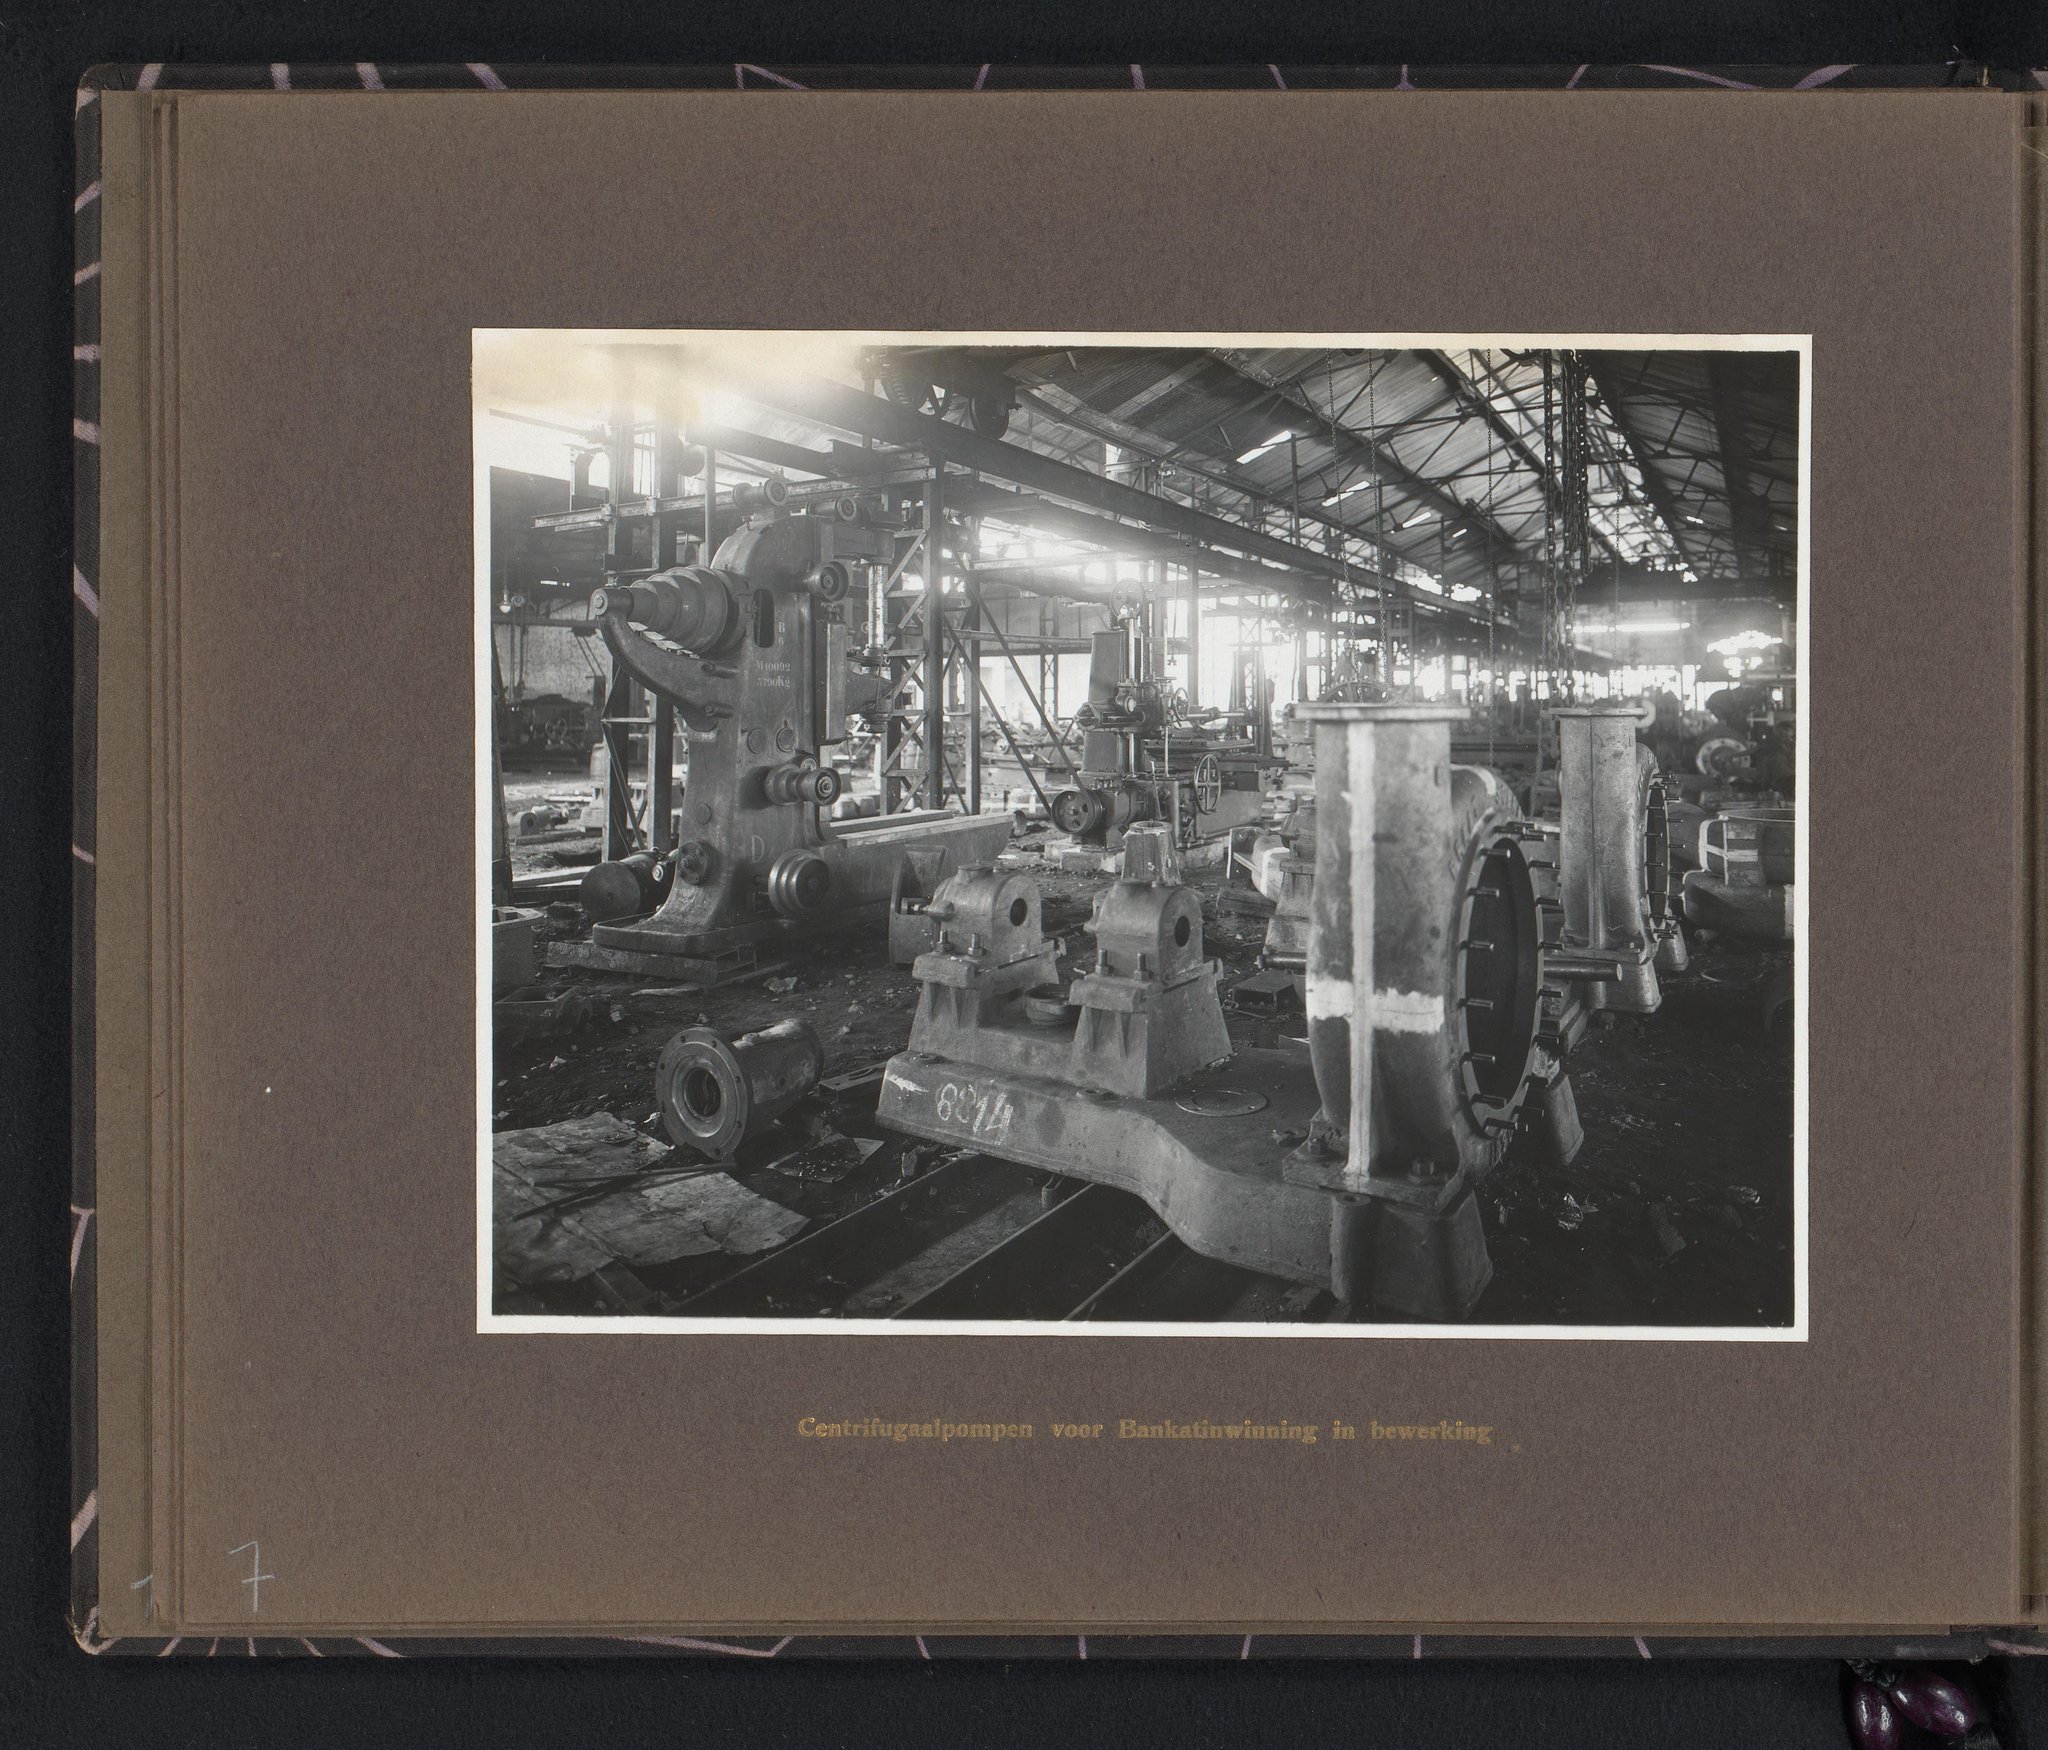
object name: album leaf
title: Centrifugaalpompen voor Bankatinwinning in bewerking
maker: Anonymous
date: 1916-1924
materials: cardboard, photographic support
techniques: gelatin silver print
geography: surabaya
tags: colonial system, factory-interior, machine shop, machines; parts of machines; tools and appliances, java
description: Albumblad met een foto van de fabricage van pompen. Vervaardigd door Machinefabriek Braat en bestemd voor de Banka-tinwinning. Onderdeel van het fotoalbum Machinefabriek Braat Soerabaia-Djocja-Tegal, ca. 1916-1924.